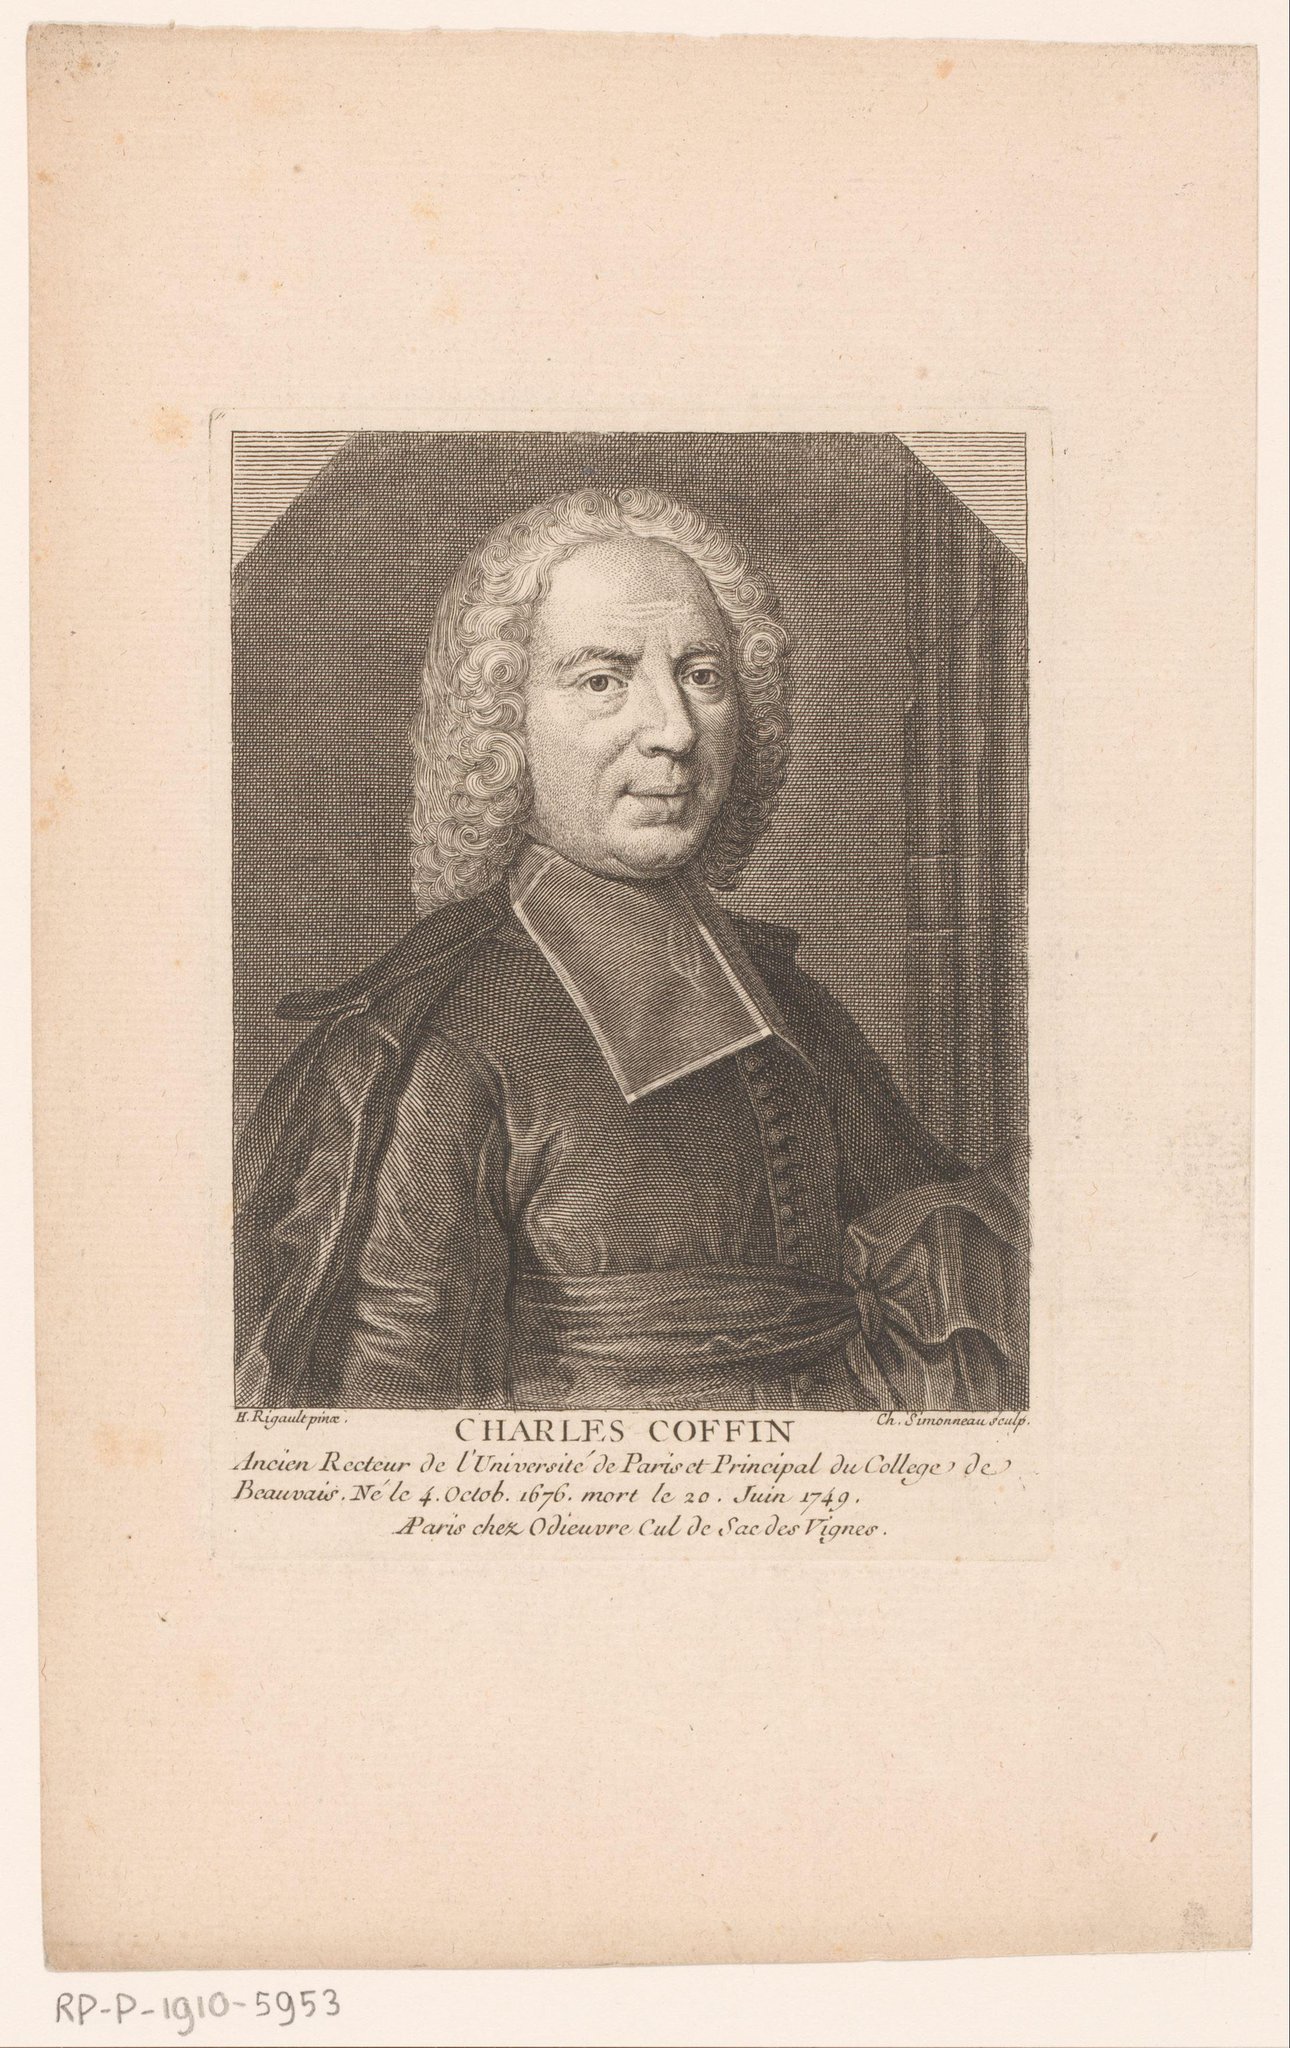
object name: print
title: Portret van Charles Coffin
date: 1655-1728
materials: paper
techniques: engraving, etching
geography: paris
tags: paris, historical persons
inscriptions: collector's mark: Lugt 2228